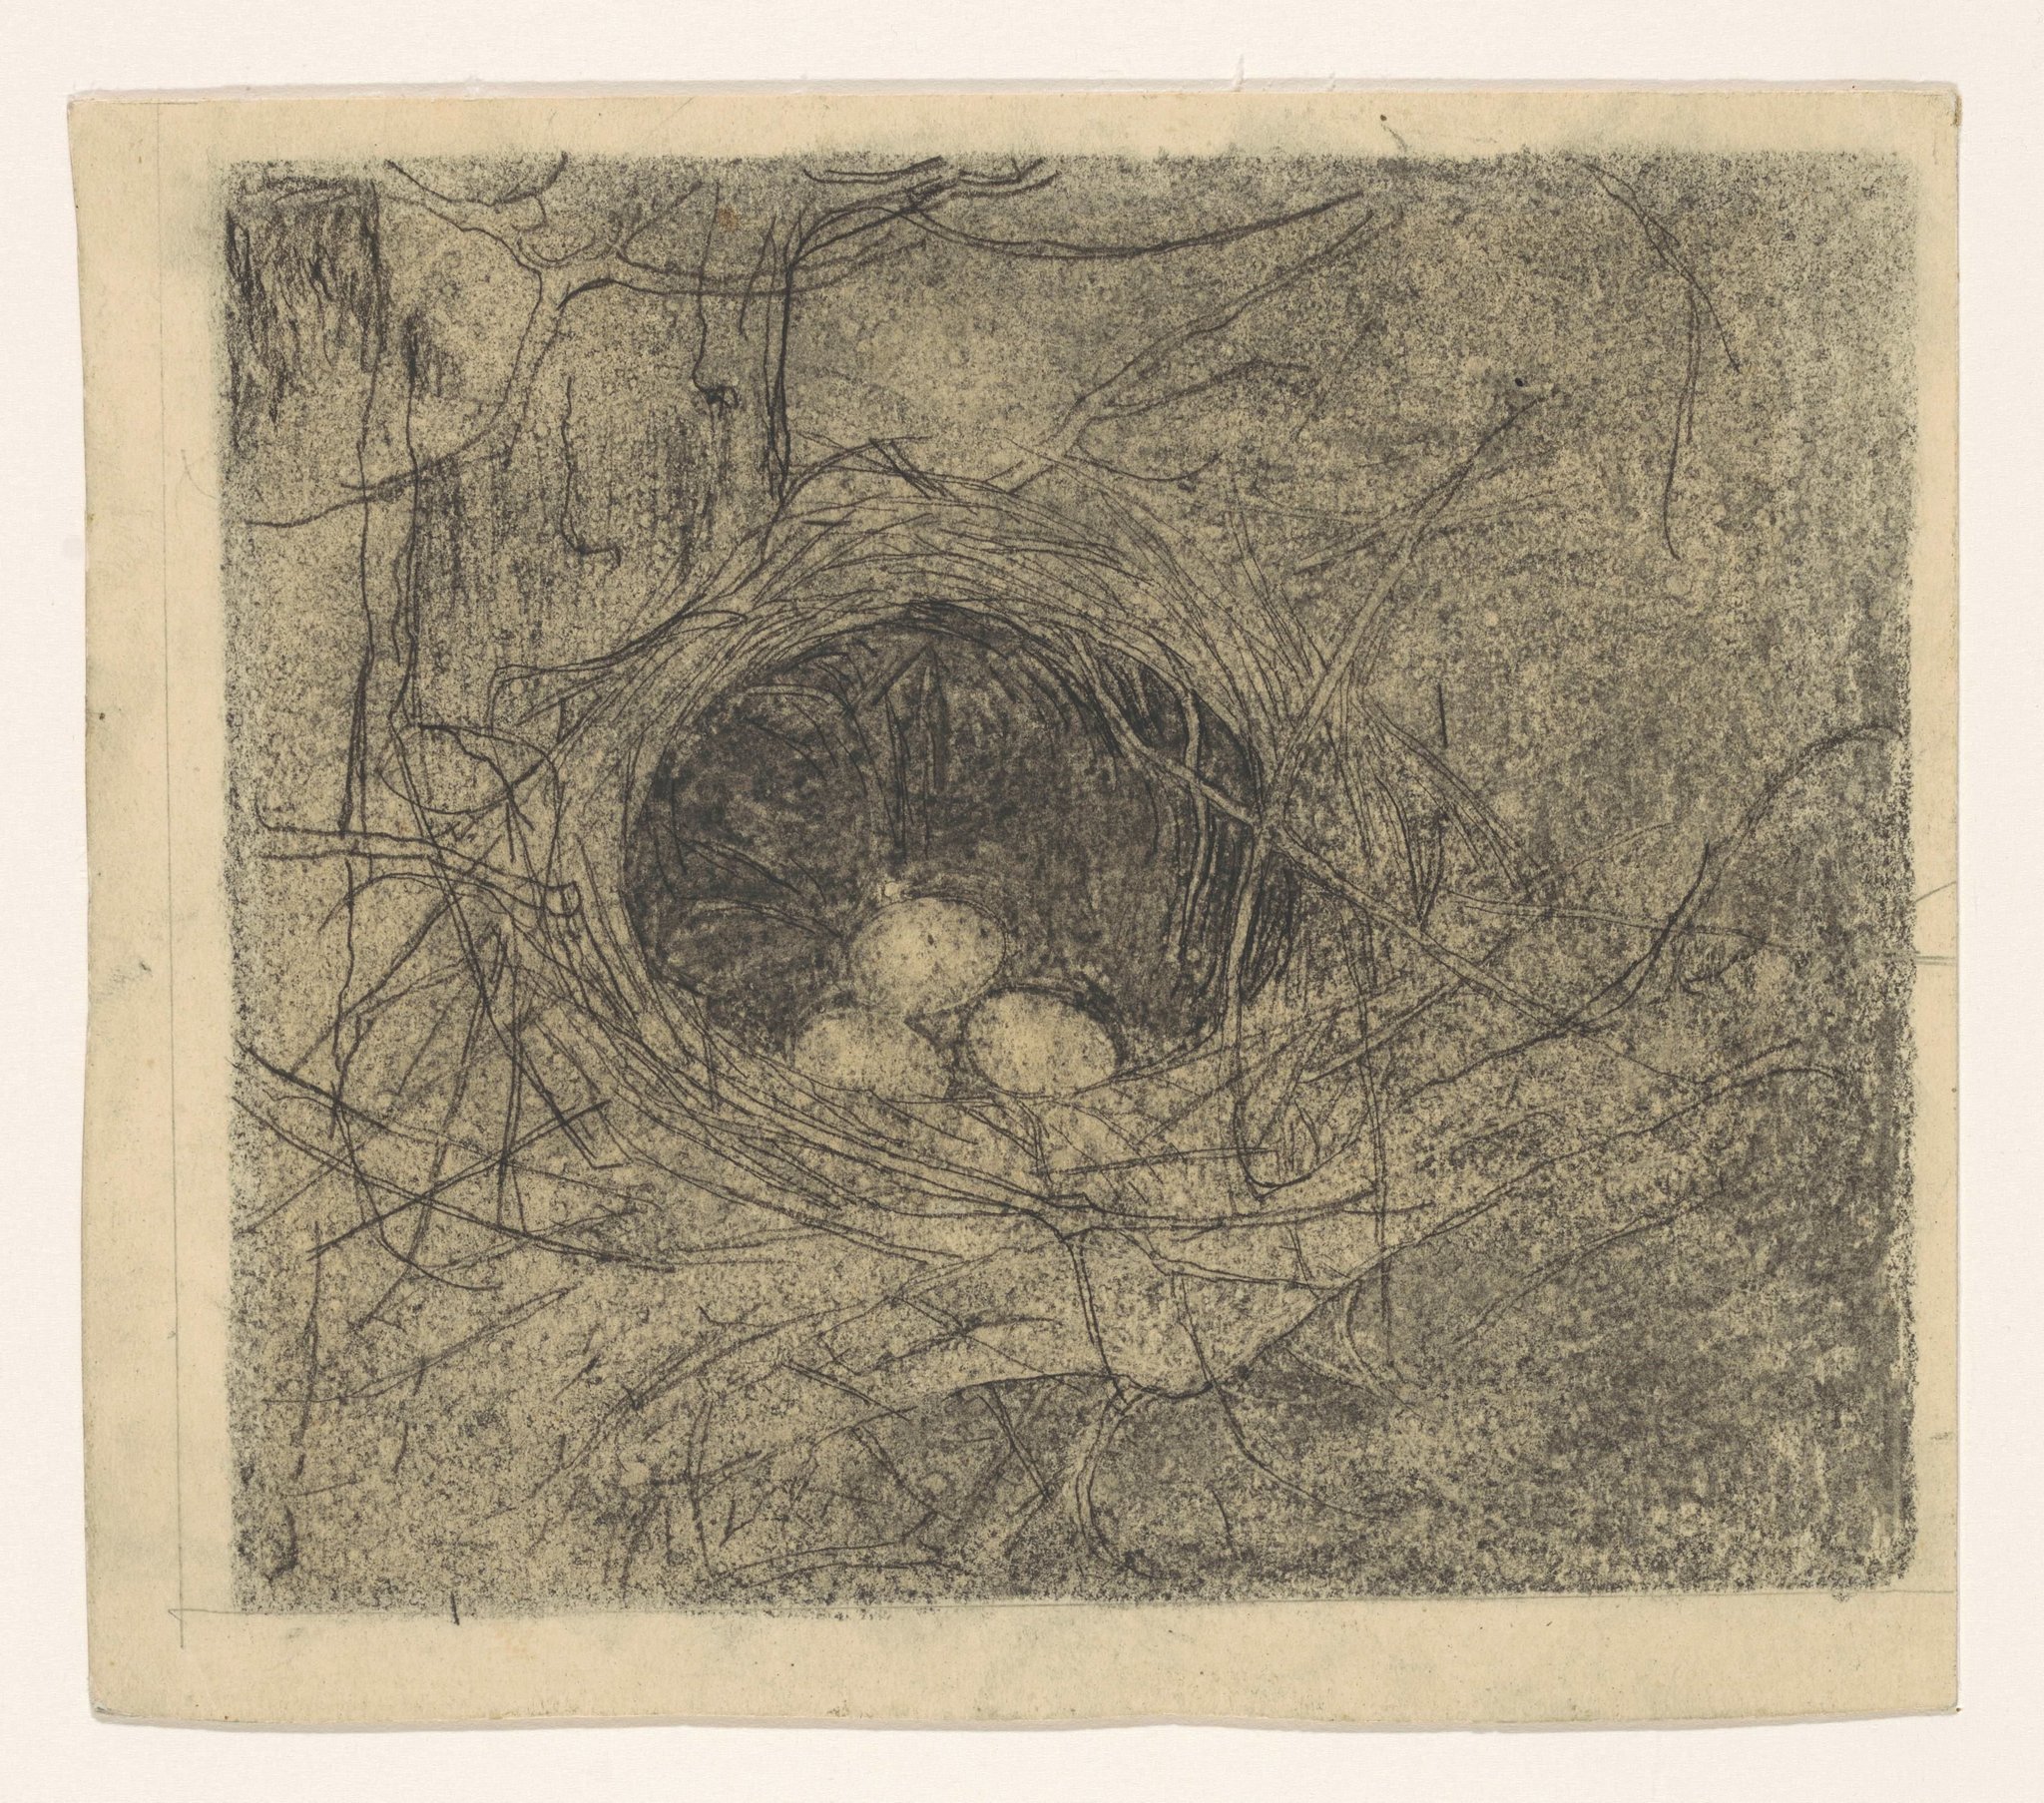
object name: drawing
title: Nest met drie eieren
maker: jan mankes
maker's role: draughtsman, painter, print maker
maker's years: 1889-1920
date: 1899-1920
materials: chalk, paper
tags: birds (+ egg)